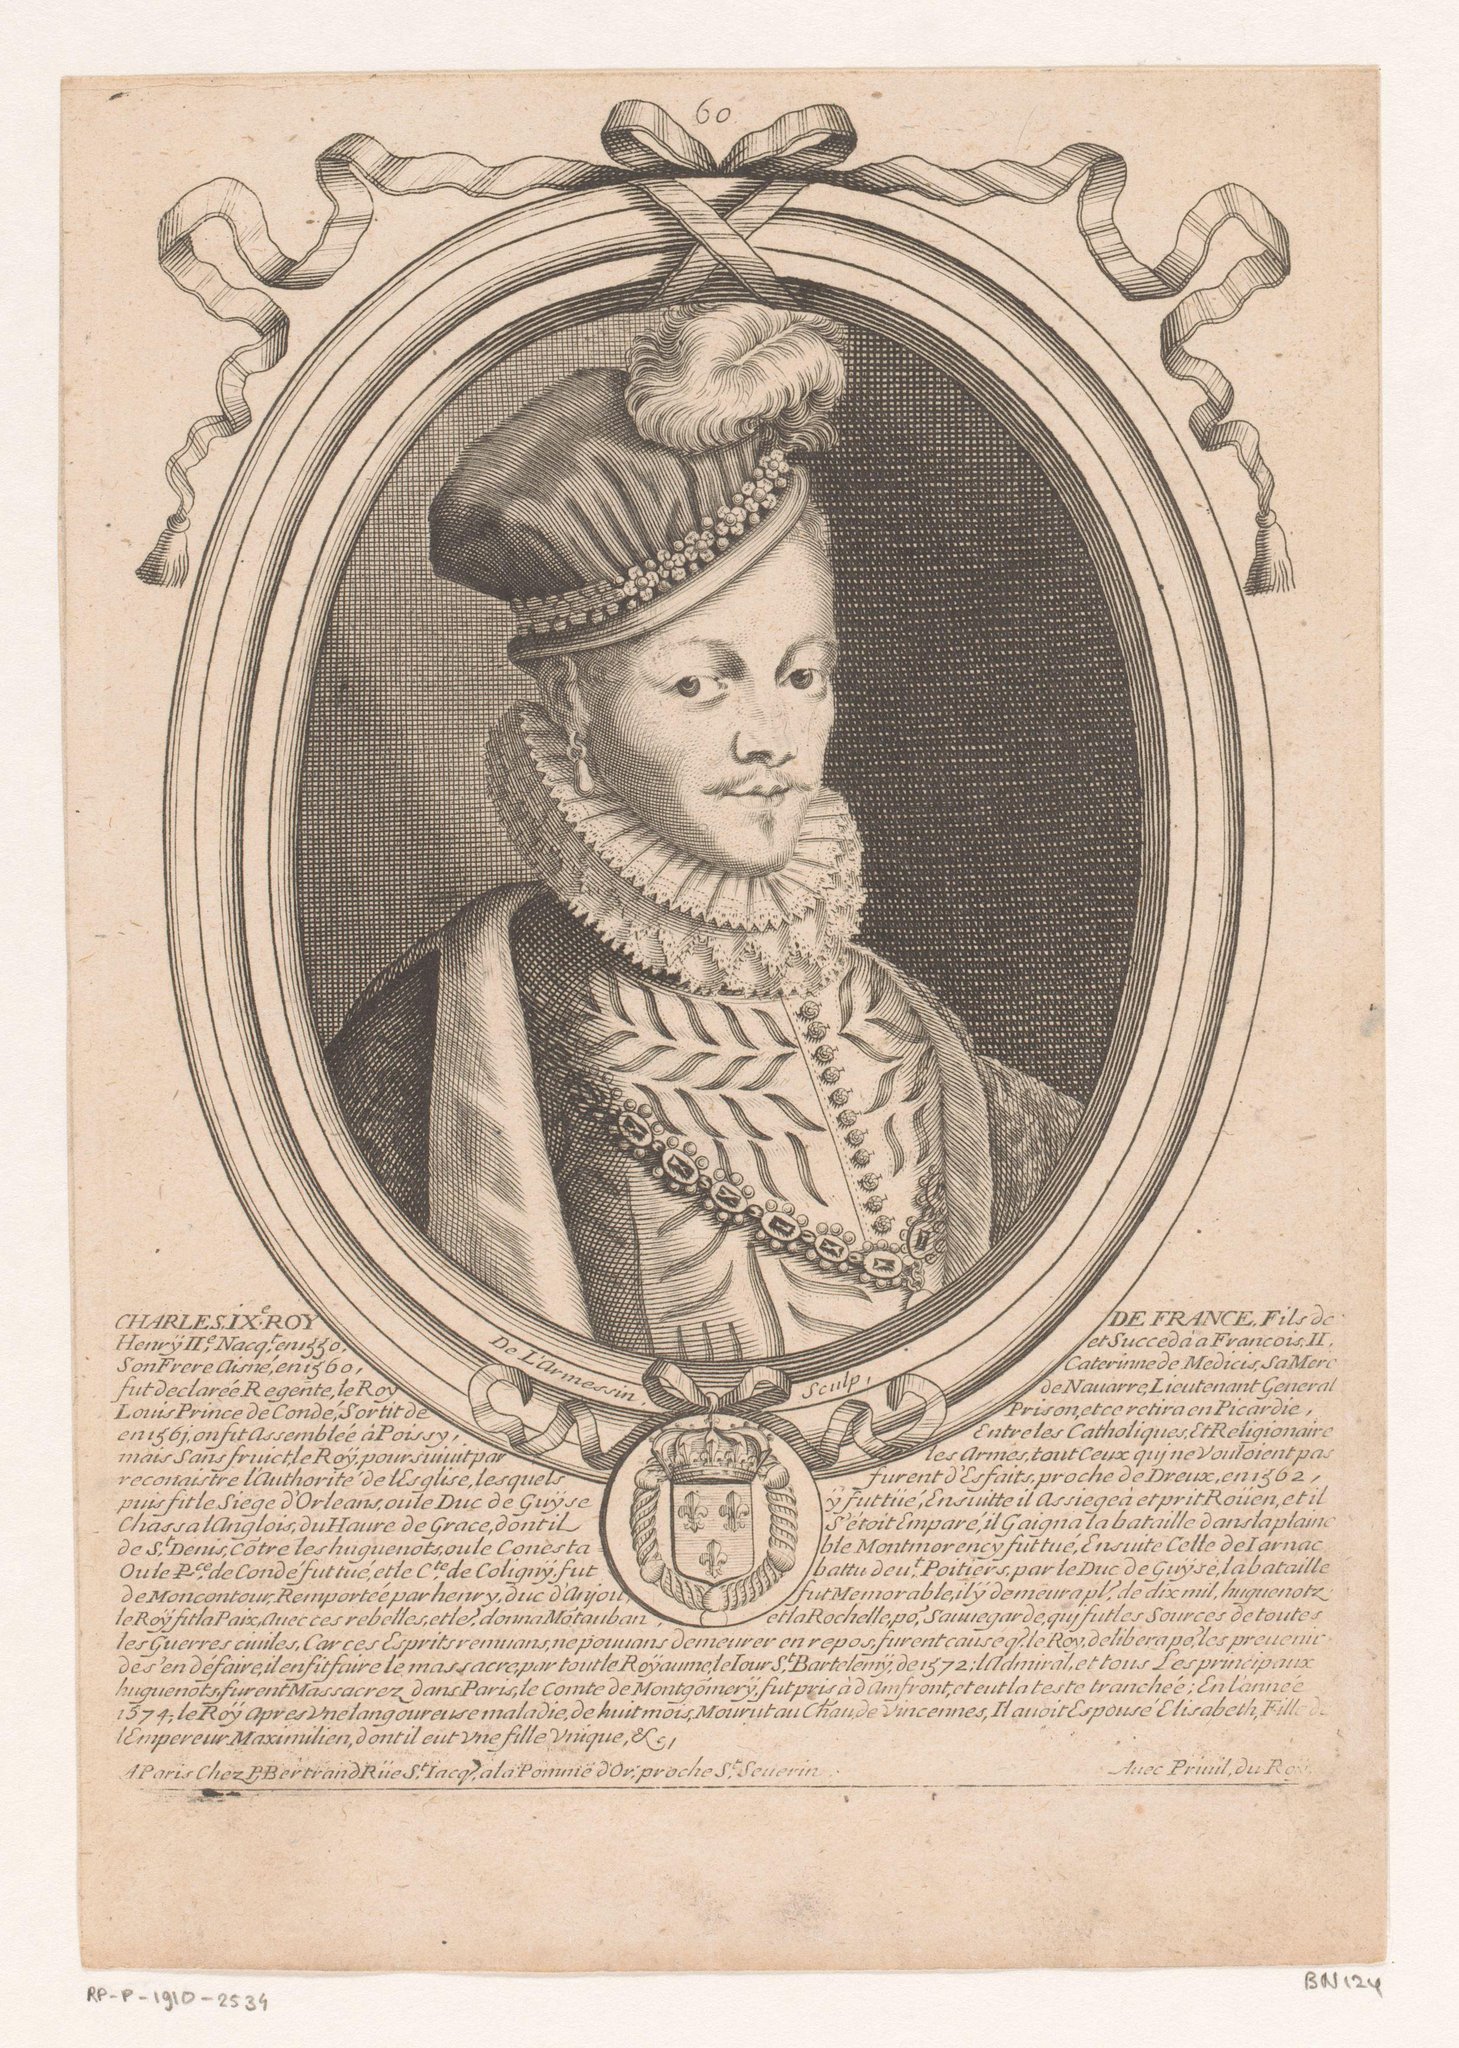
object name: print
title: Portret van Karel IX, koning van Frankrijk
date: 1642-1678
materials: paper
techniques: engraving, etching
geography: france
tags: karel ix (koning van frankrijk), historical persons, king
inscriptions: collector's mark: Lugt 2228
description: Maakt deel uit van een grootschalige serie met portretten van prominente figuren. Binnen de serie bevindt zich een sectie getiteld 'Les Augustes Représentations De tous les Roys De France depuis Pharamond Iusqu'à Louys XIIII'. De serie werd respectievelijk uitgegeven door Pierre Bertrand, door zijn weduwe en door De Larmessin zelf.